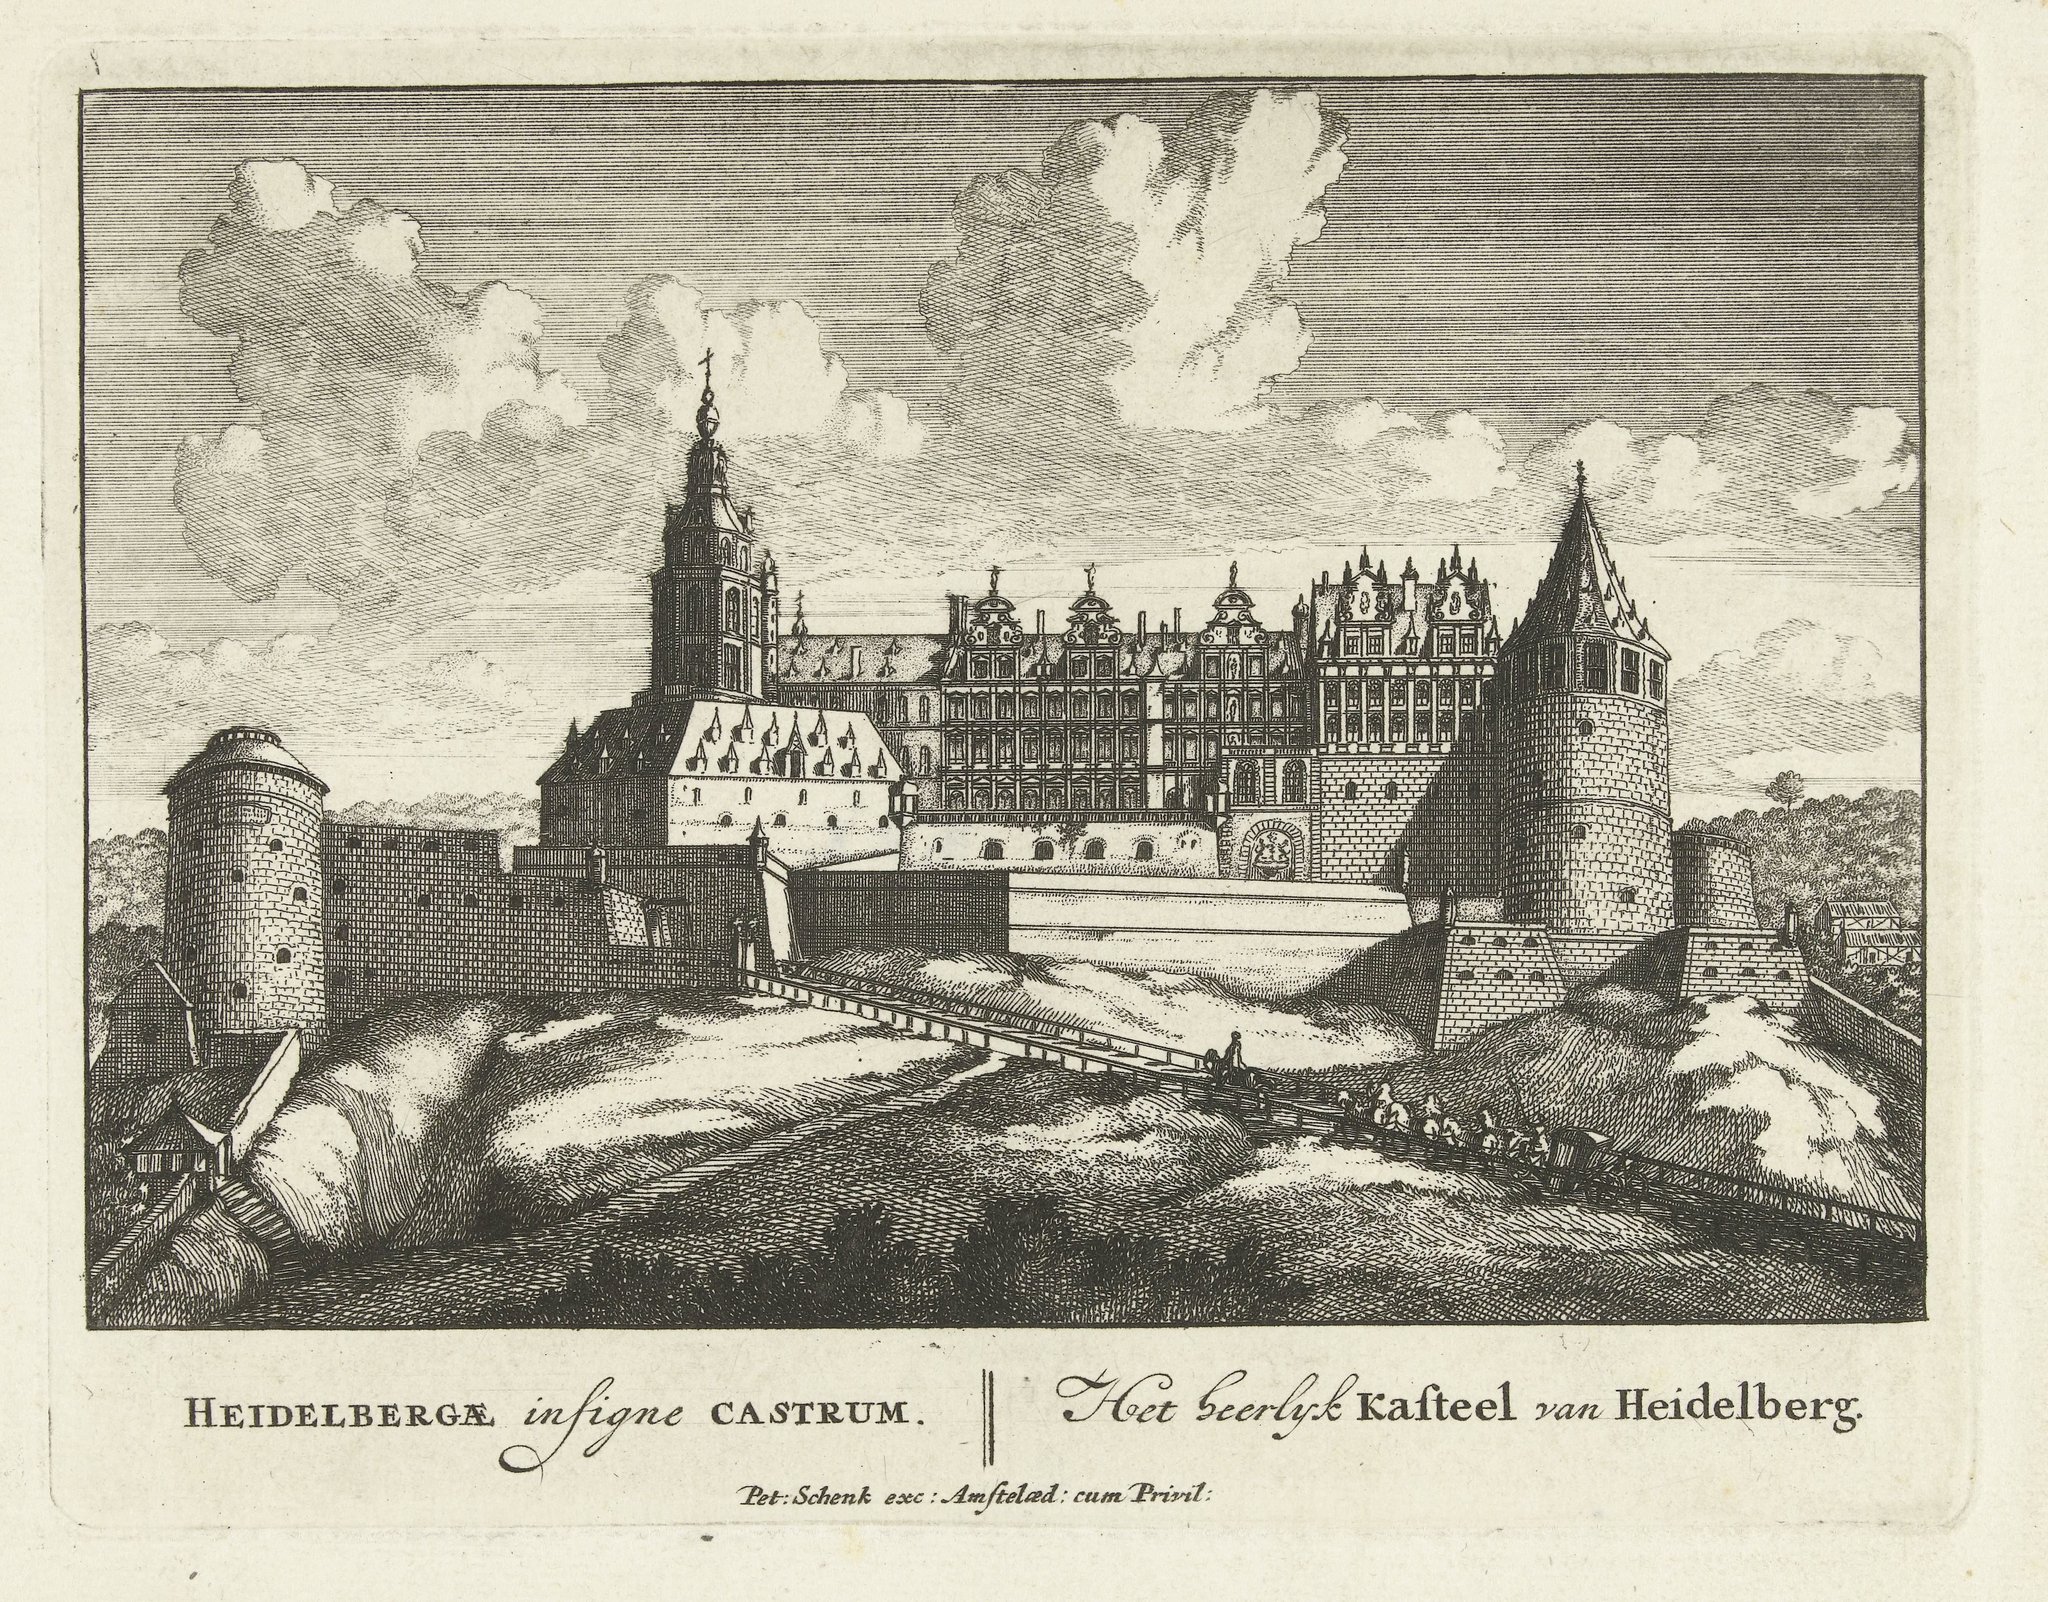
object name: print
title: Admirandorum quadruplex spectaculum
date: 1694-1697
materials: paper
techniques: etching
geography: amsterdam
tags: castle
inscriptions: collector's mark: Lugt 2228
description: Prent uit een serie van 71 prenten met Rijnlandschappen, gezichten op vorstelijke paleizen en stadsgezichten uit Den Haag en Amsterdam. Dit is prent nummer 2.